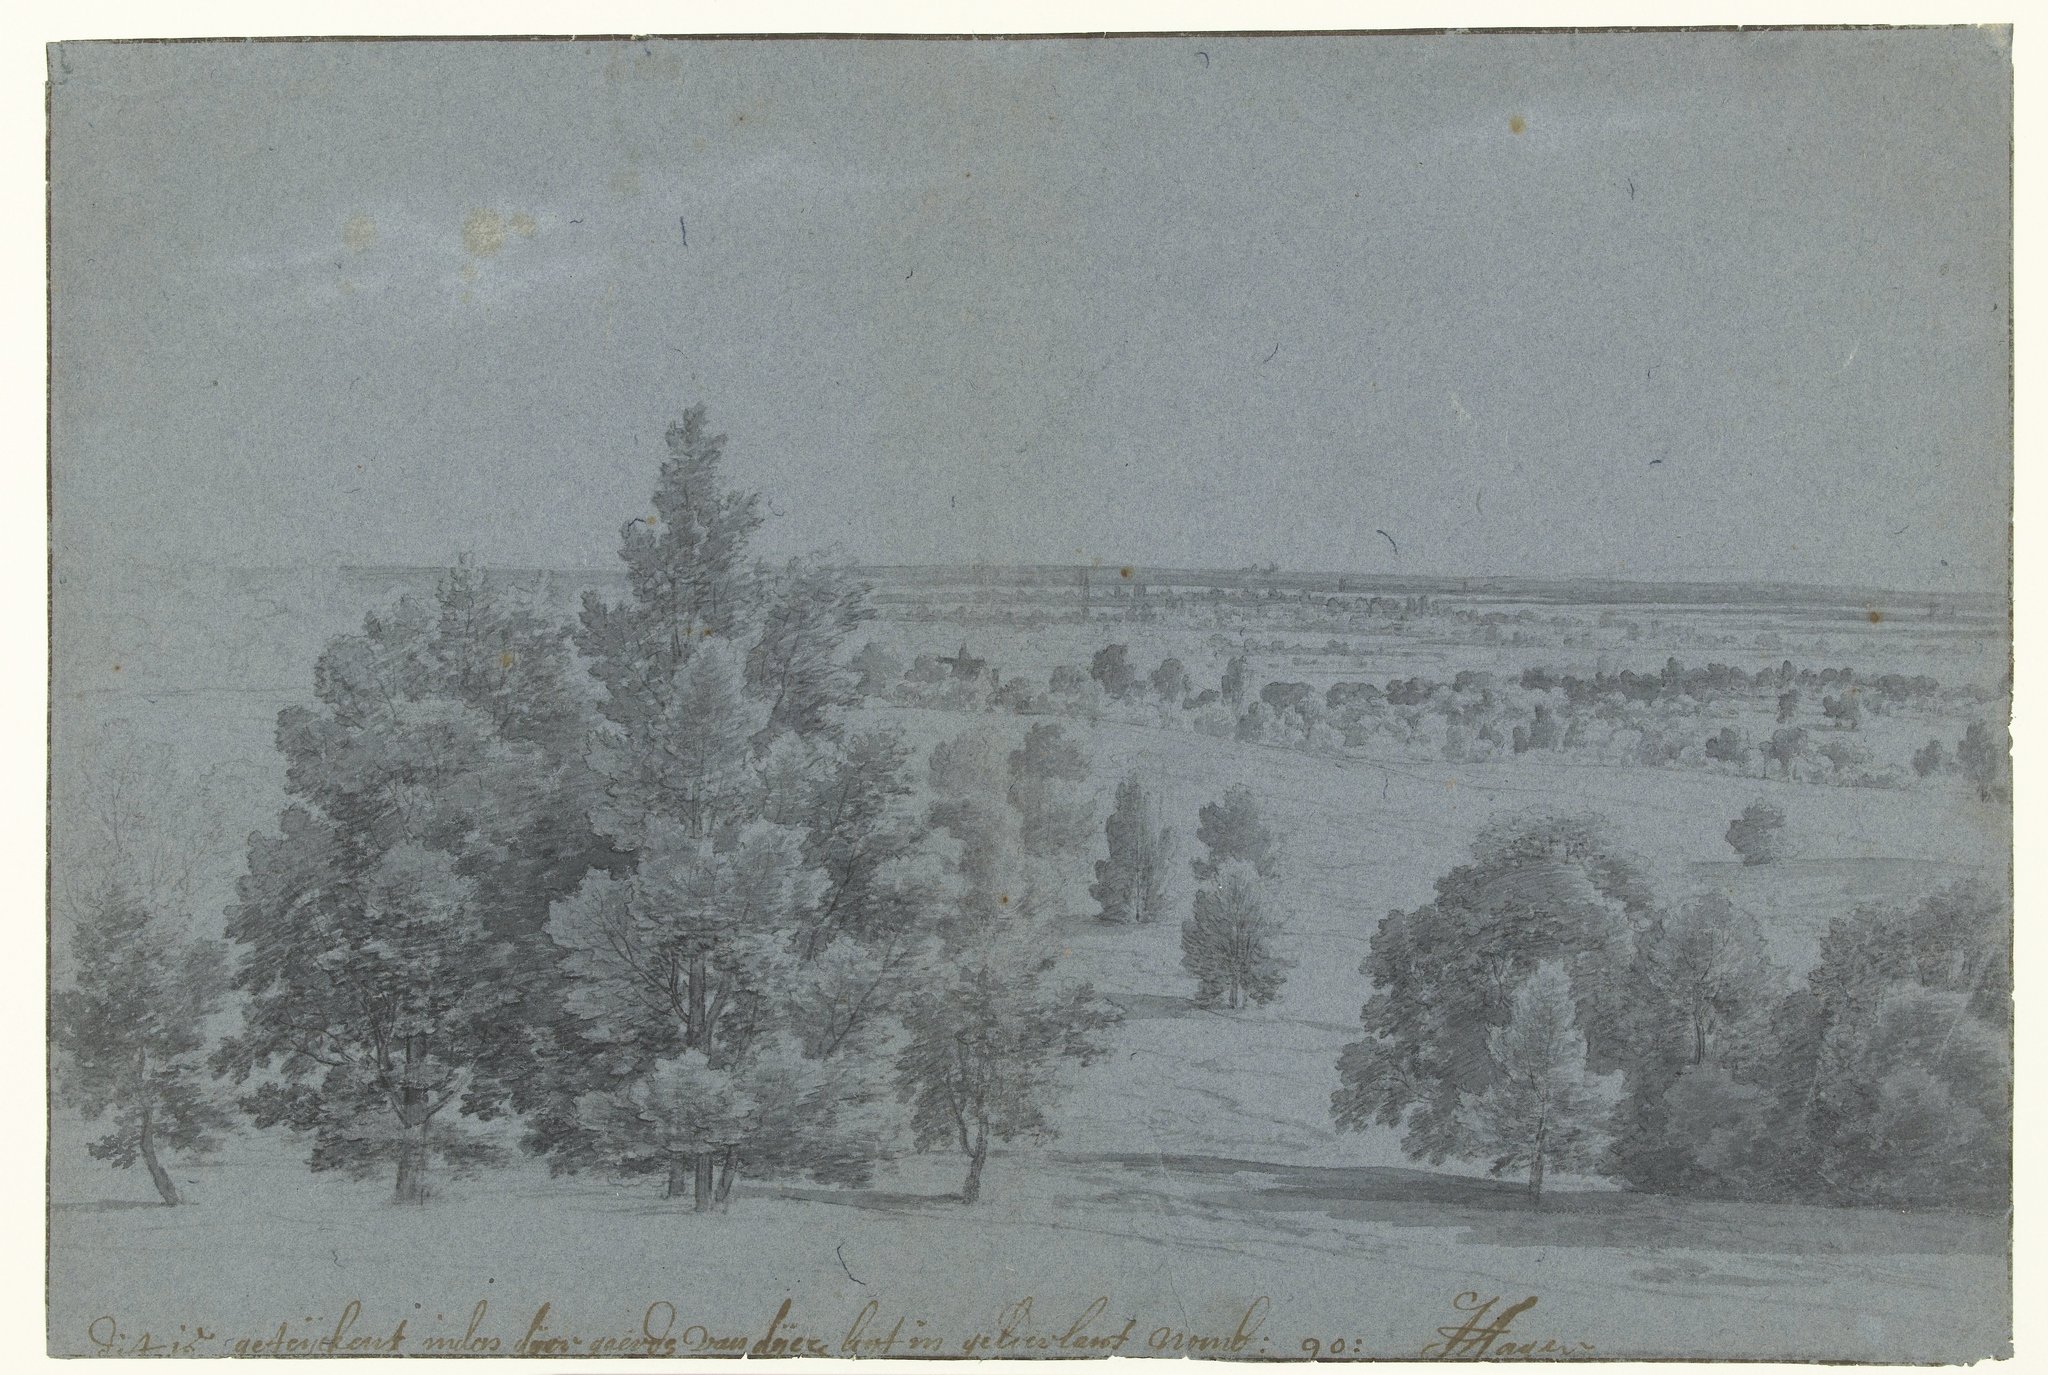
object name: drawing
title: Gelders vergezicht bij Dieren (?)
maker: joris van der haagen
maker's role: draughtsman, painter, print maker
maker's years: 1615-1669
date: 1625-1669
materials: chalk, paper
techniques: brush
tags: landscapes in the temperate zone, gelderland